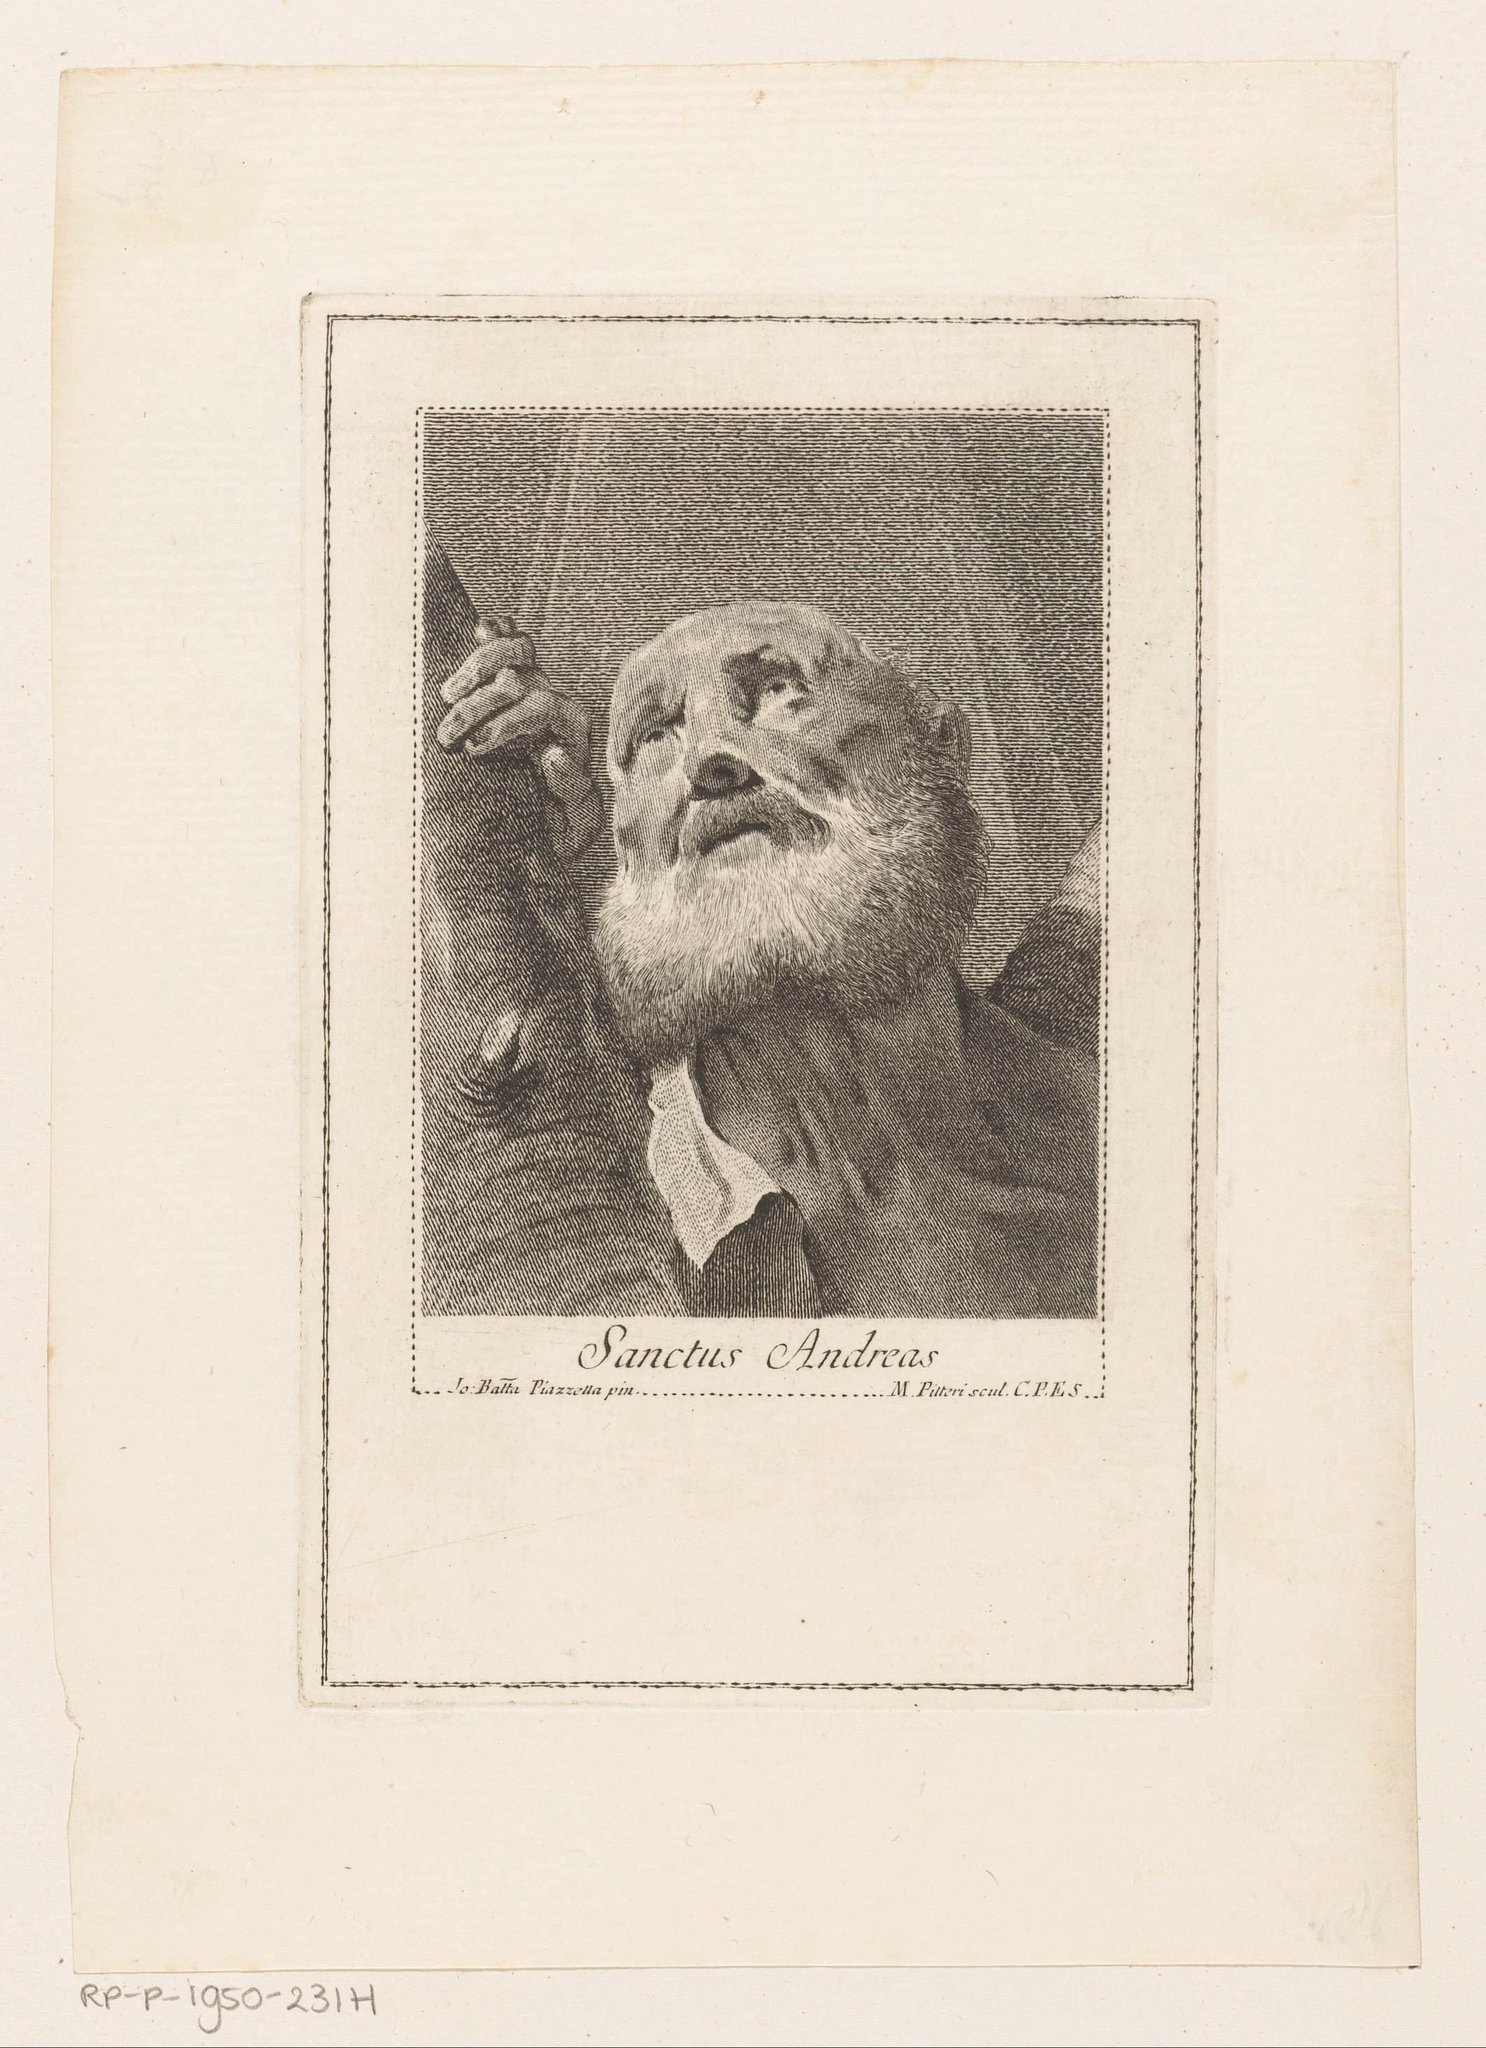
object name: print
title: Opera dipinta da Giambattista Piazzetta incisa da Marco Pitteri Veneto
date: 1712-1786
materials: paper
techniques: engraving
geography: venice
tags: the apostle andrew; possible attributes: book, x-shaped cross, fish, fishing-net, rope, scroll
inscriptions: collector's mark: Lugt 2228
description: In de literatuur worden alleen de twaalf apostelen samen als serie geteld. Maar uit de collectie van het Rijksmuseum kunnen we opmaken dat de serie uit ten minste 19 prenten en een titelprent bestond.